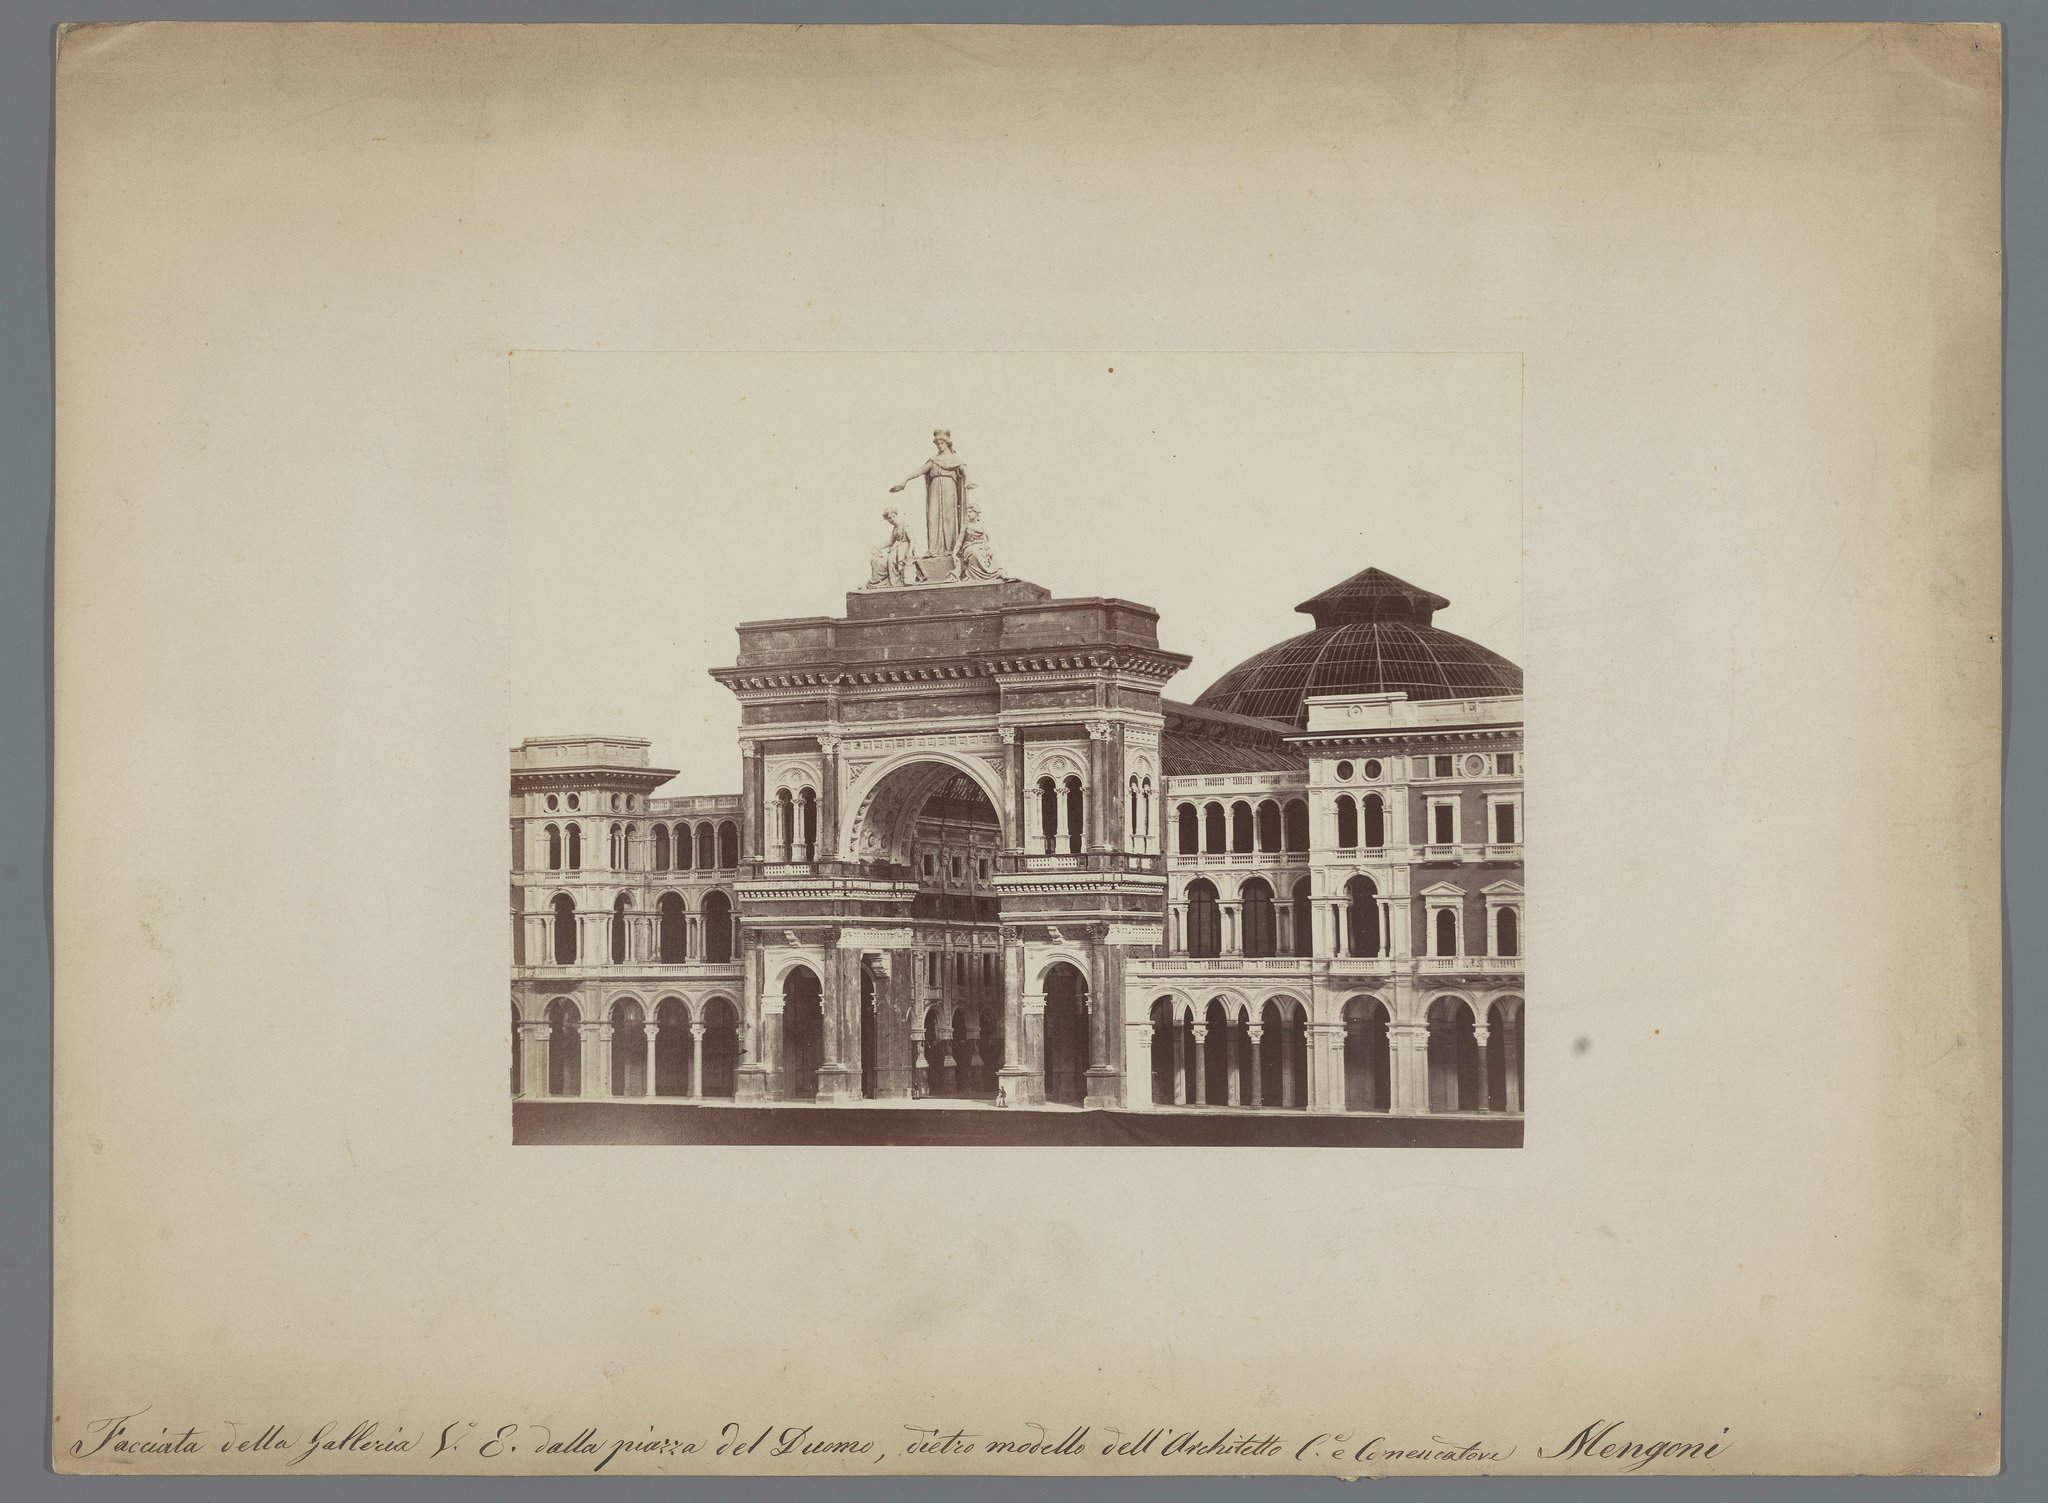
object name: stereograph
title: Gezicht op de Pont d'Arcole in Parijs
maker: Anonymous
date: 1850-1880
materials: cardboard, photographic support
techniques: albumen print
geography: paris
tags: bridge in city across river, canal, etc.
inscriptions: inscription: ‘Quai Notre dame Paris Pont d'arcole Quai de [...] Palais de Justice [...] de la cité’